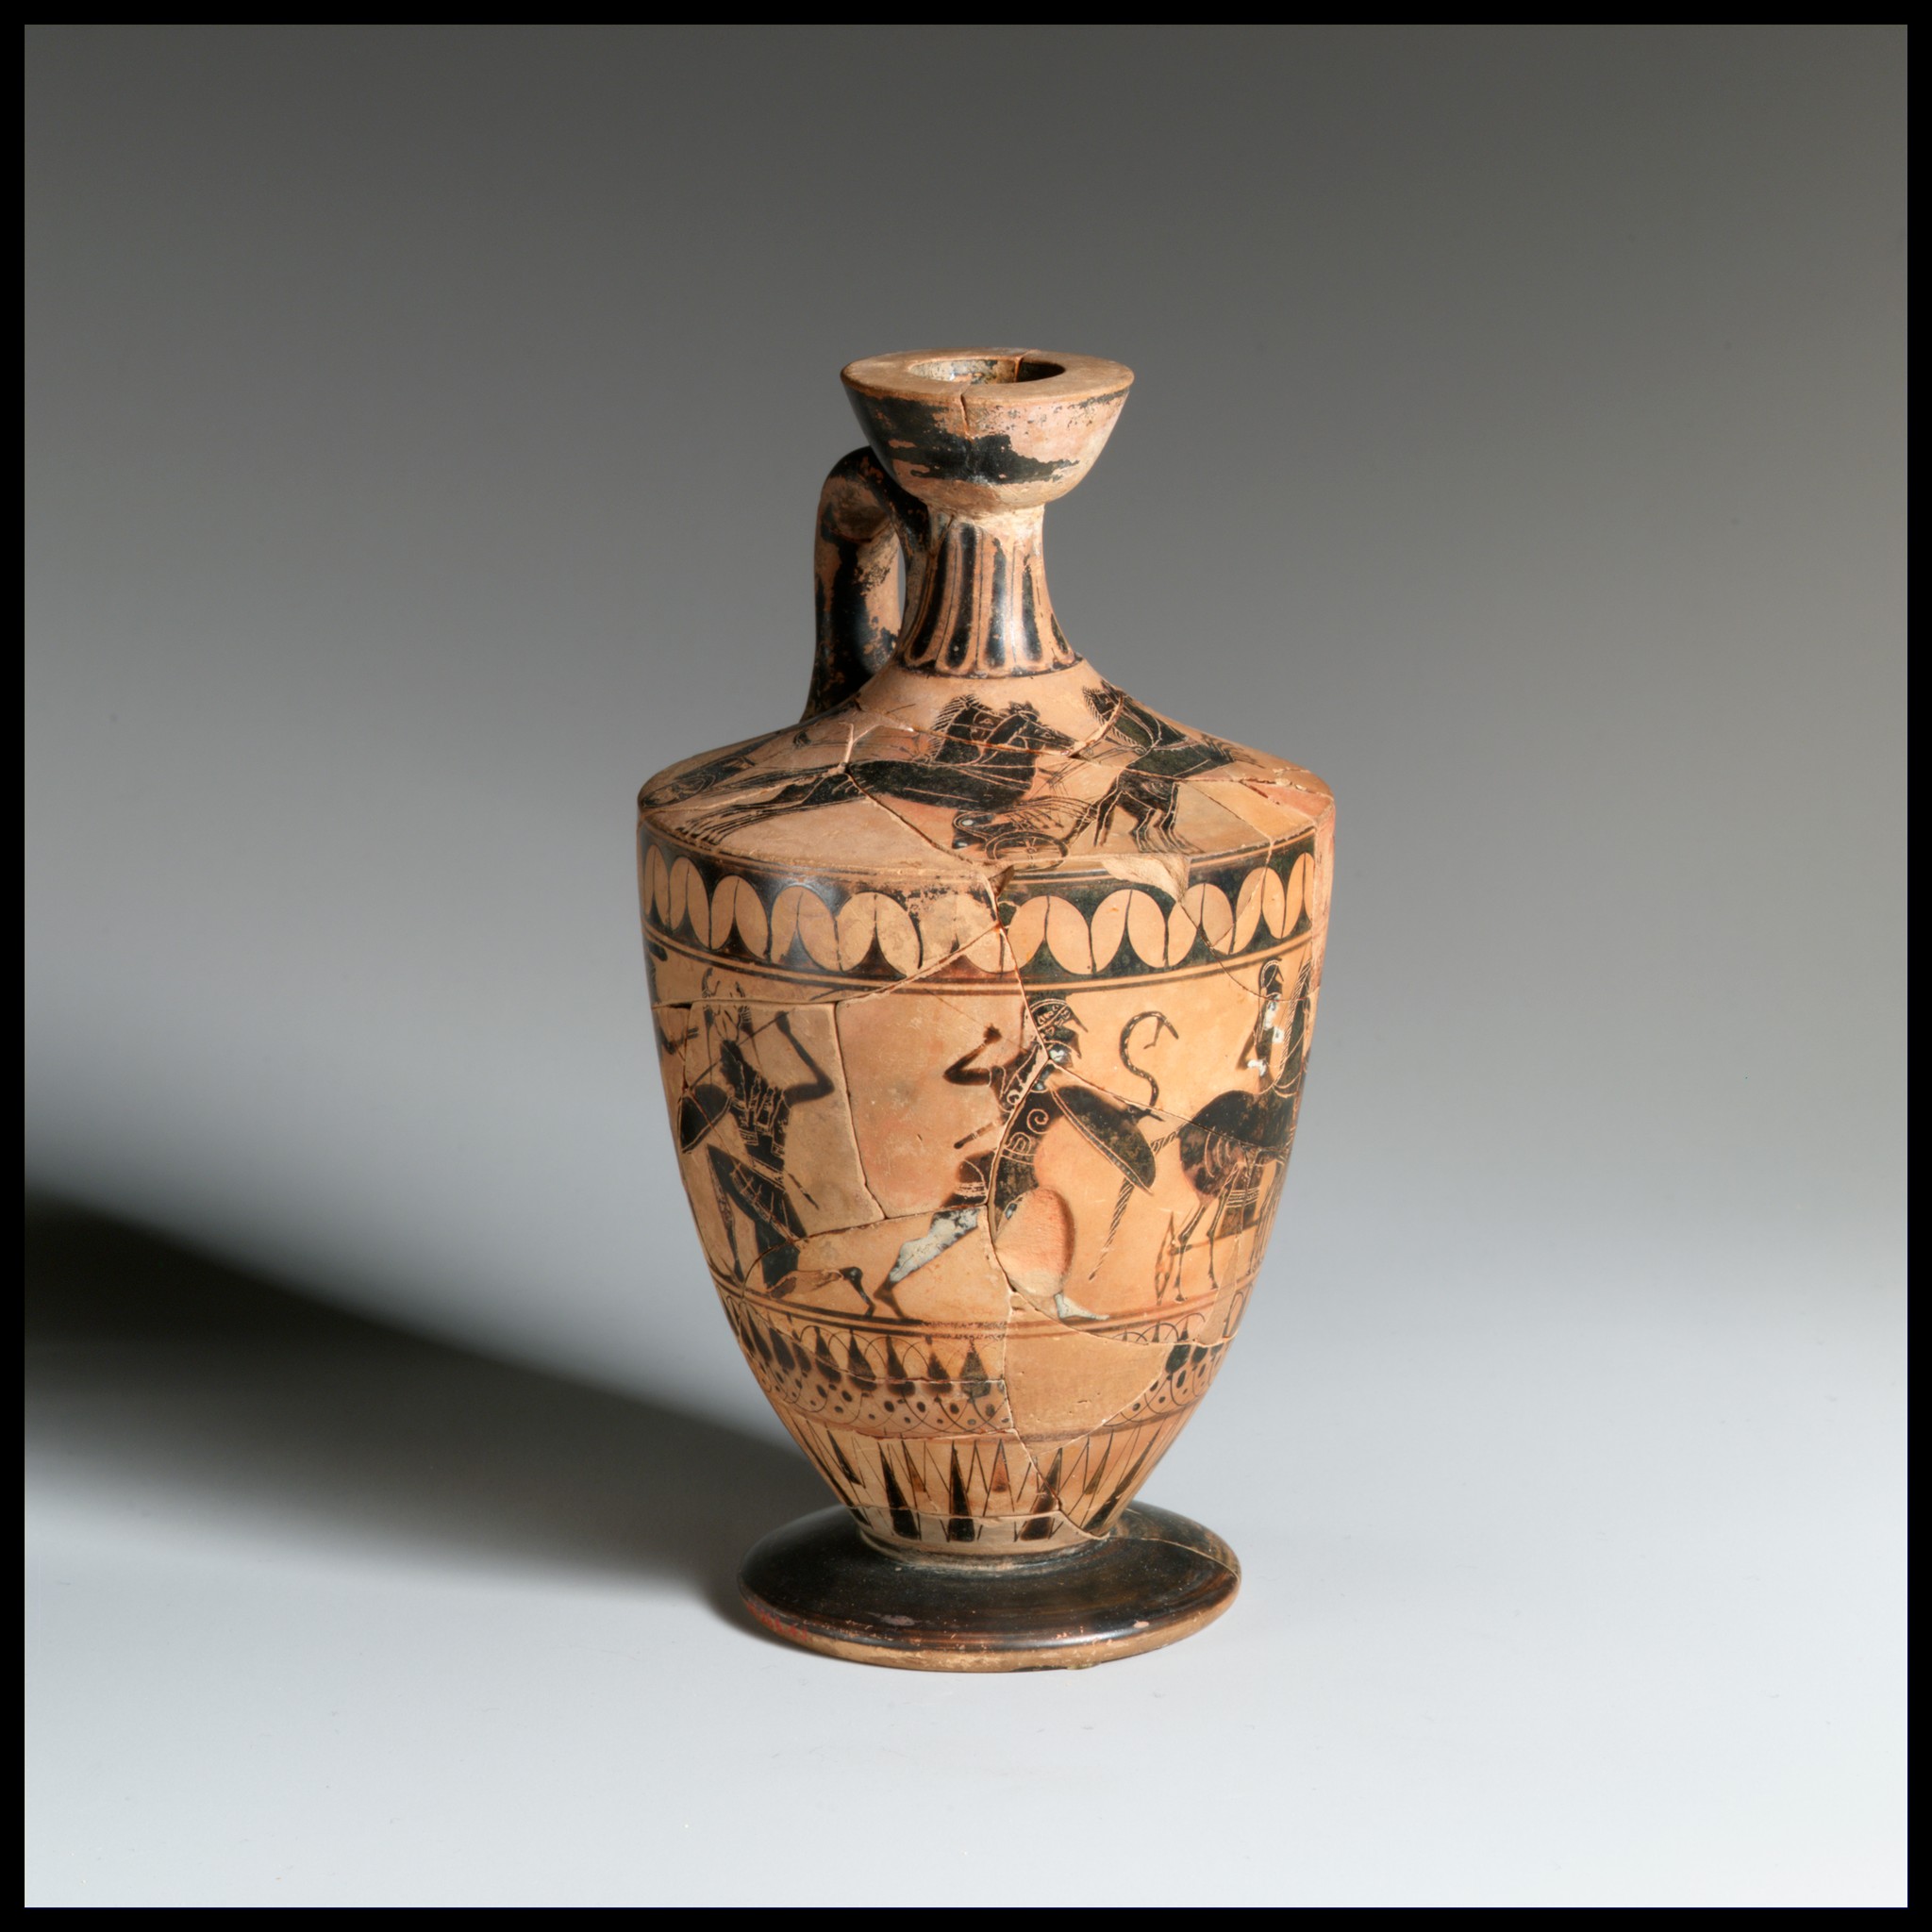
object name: lekythos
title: Terracotta lekythos (oil flask)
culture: greek, attic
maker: painter of new york 07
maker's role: artist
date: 530 BCE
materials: terracotta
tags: battles,horses,chariots